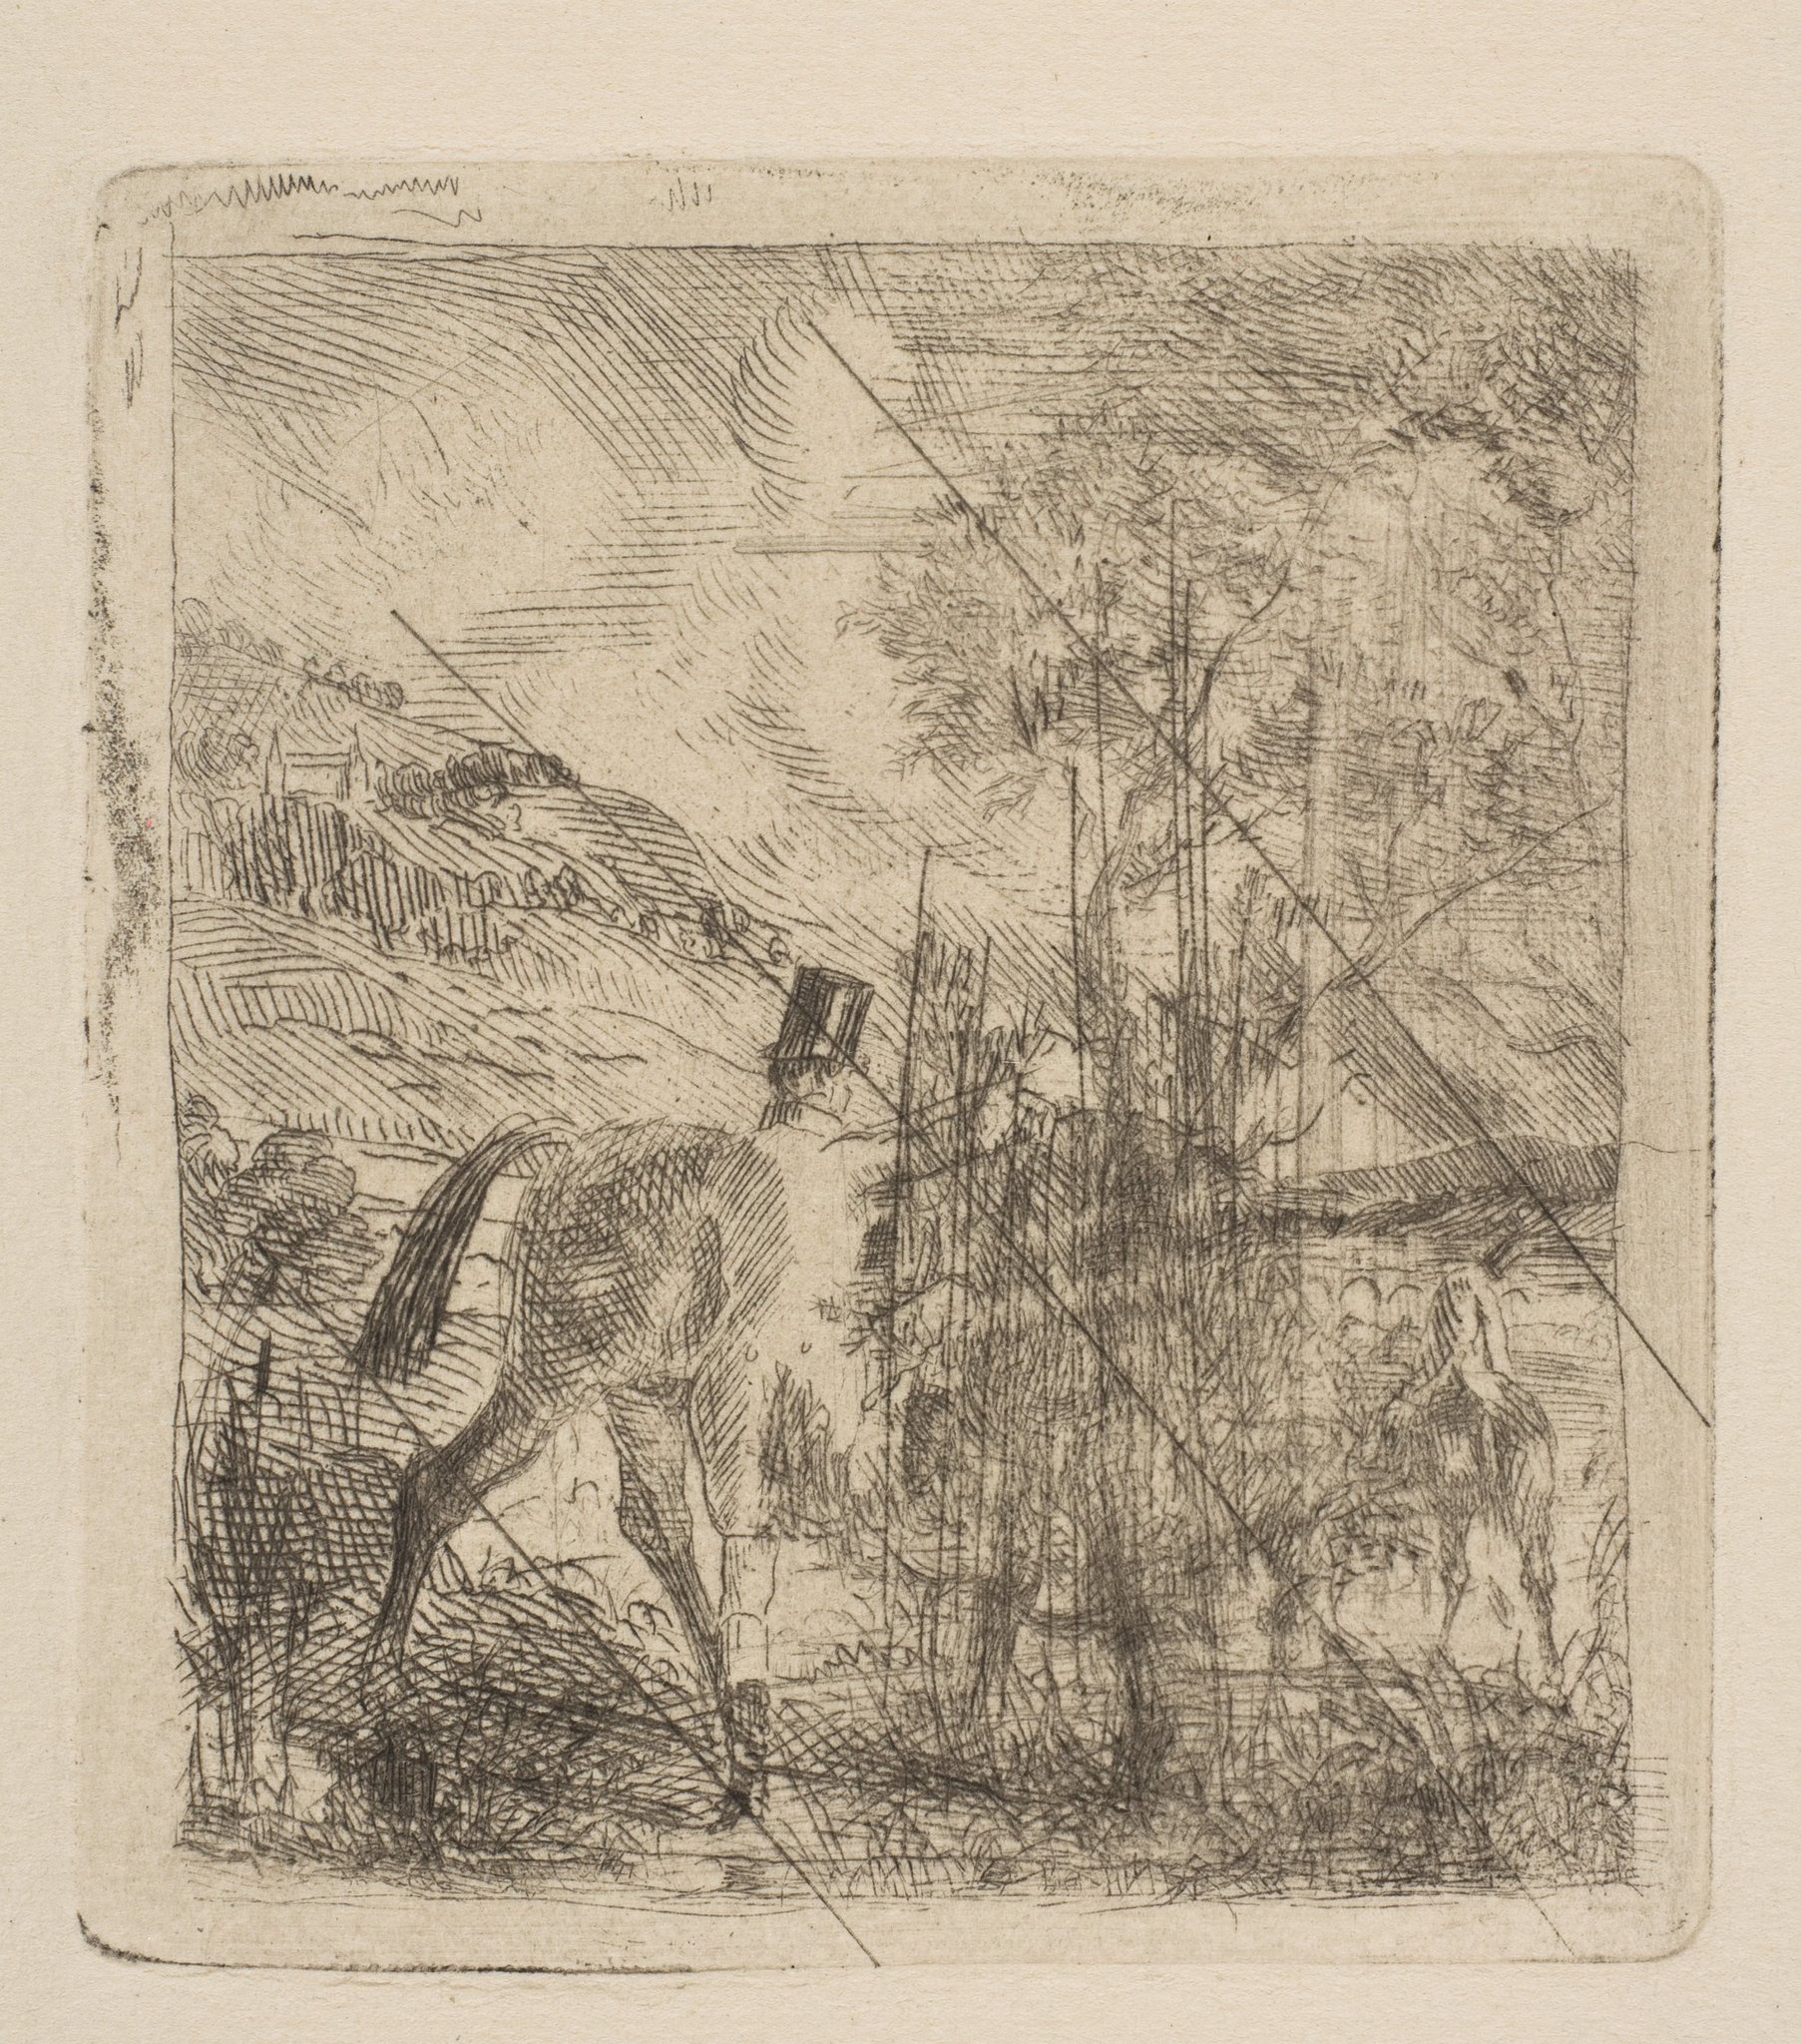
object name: print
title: The Sportsman Mounting His Horse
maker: edgar degas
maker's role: artist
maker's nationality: french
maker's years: 1834-1917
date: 1856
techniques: etching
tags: men,horses